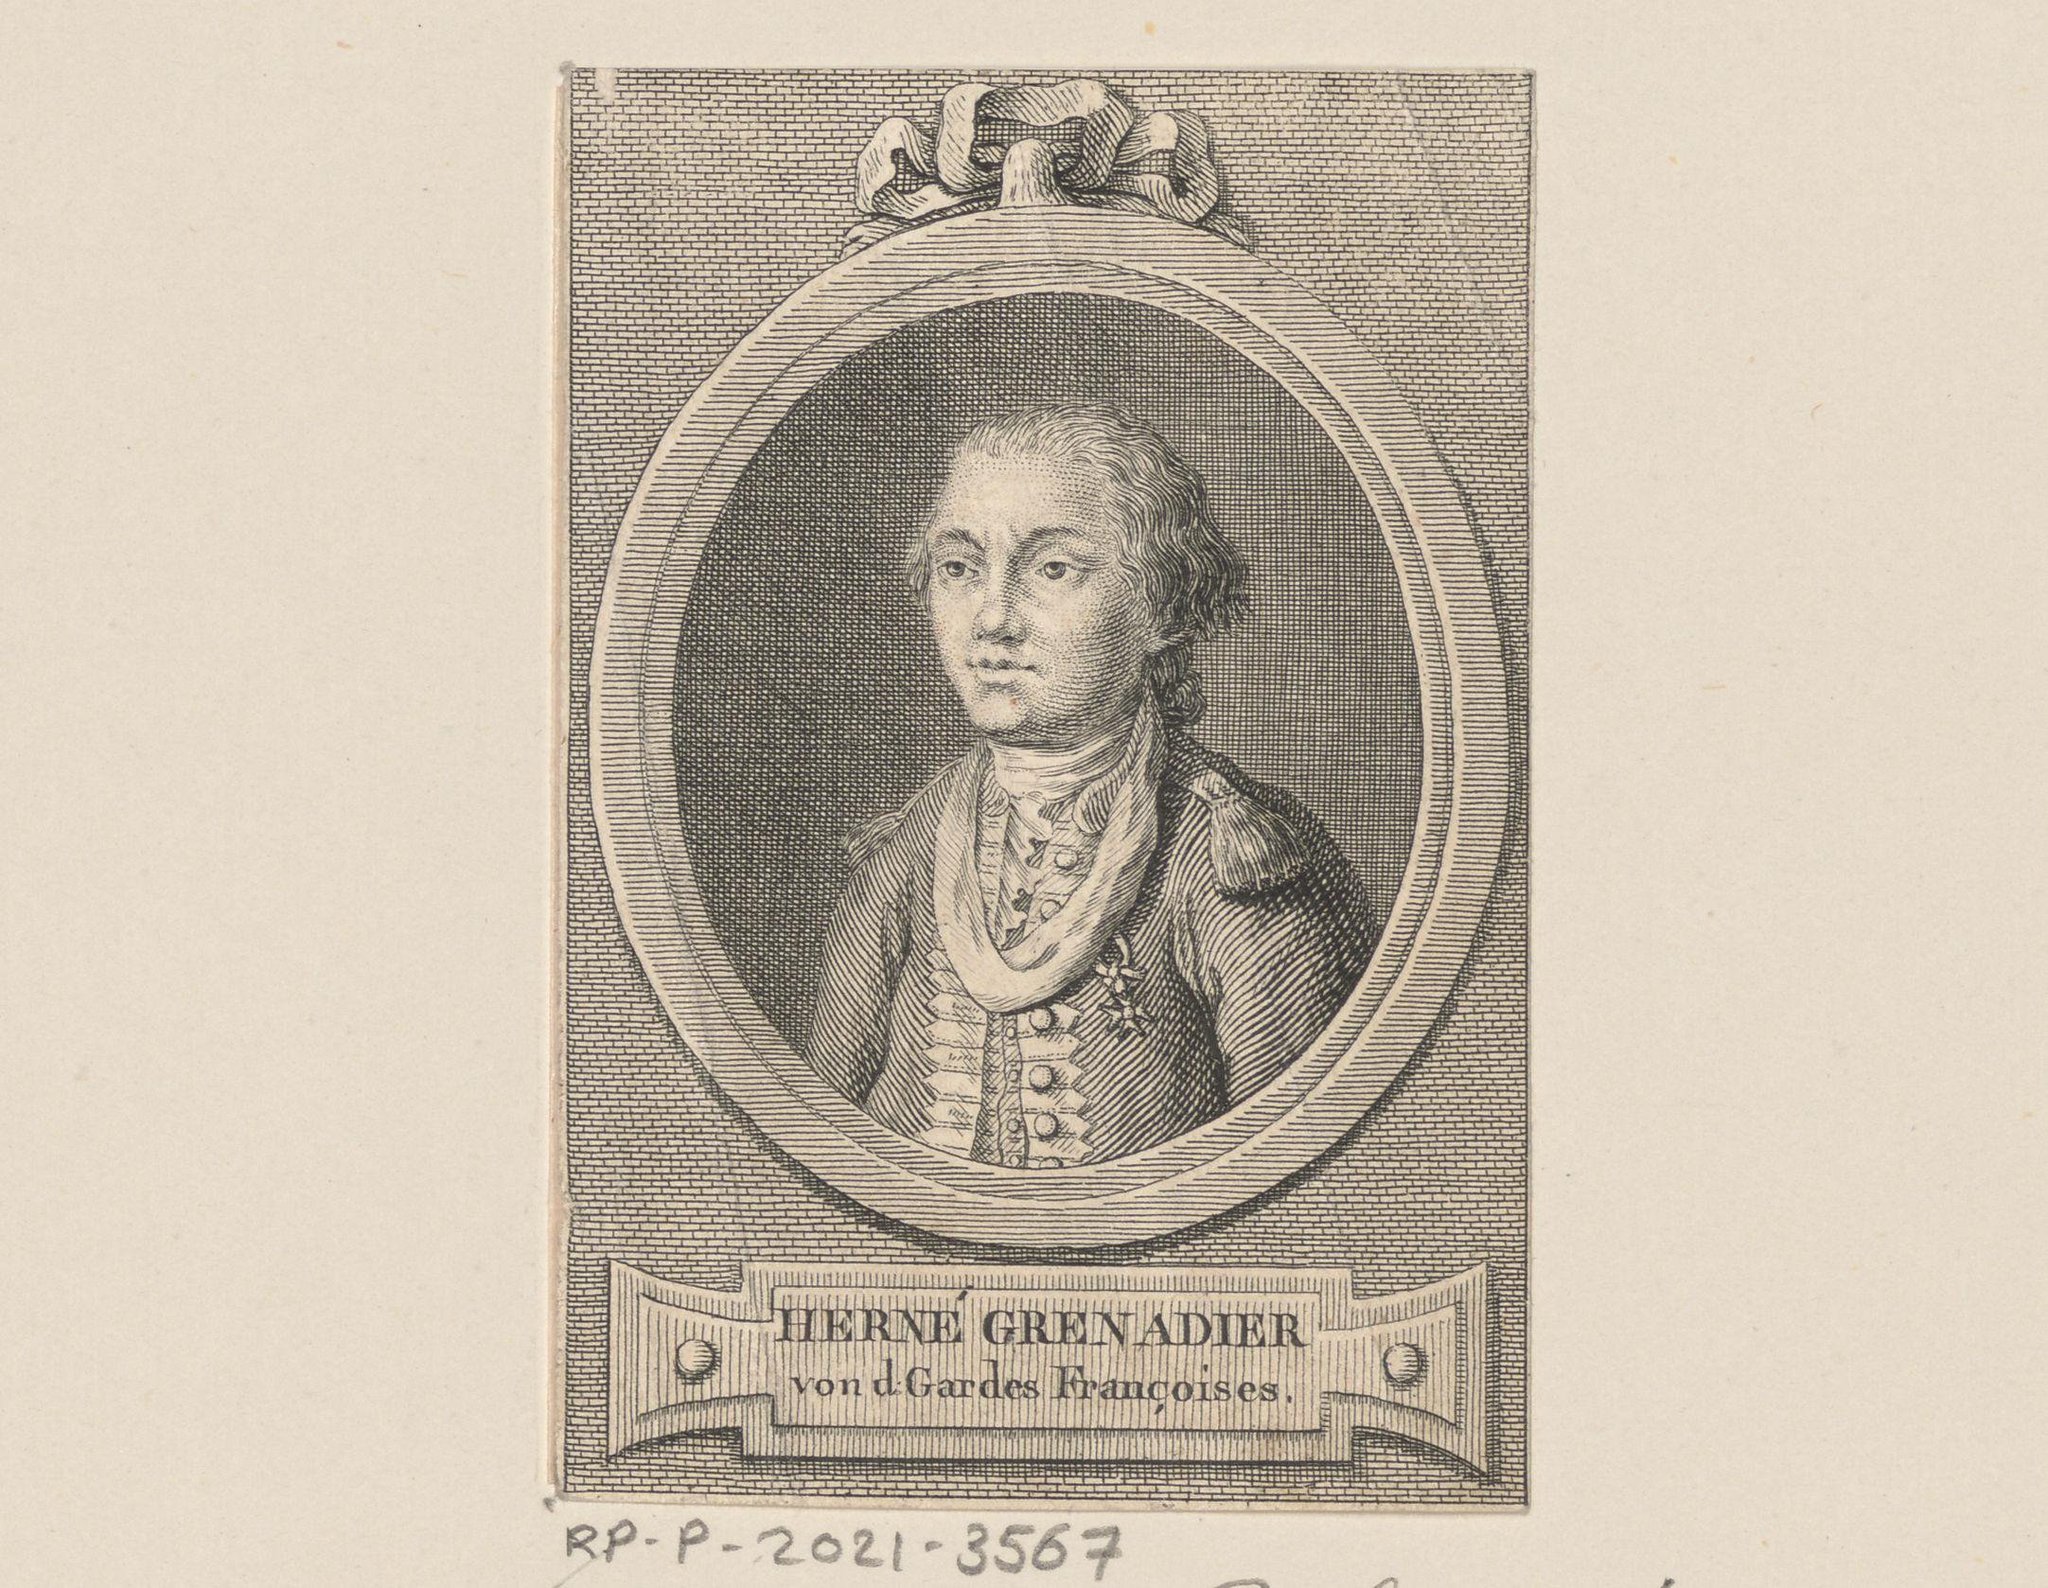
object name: print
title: Portret van Herné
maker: Anonymous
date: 1775-1799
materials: paper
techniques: engraving, etching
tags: private soldier, historical persons